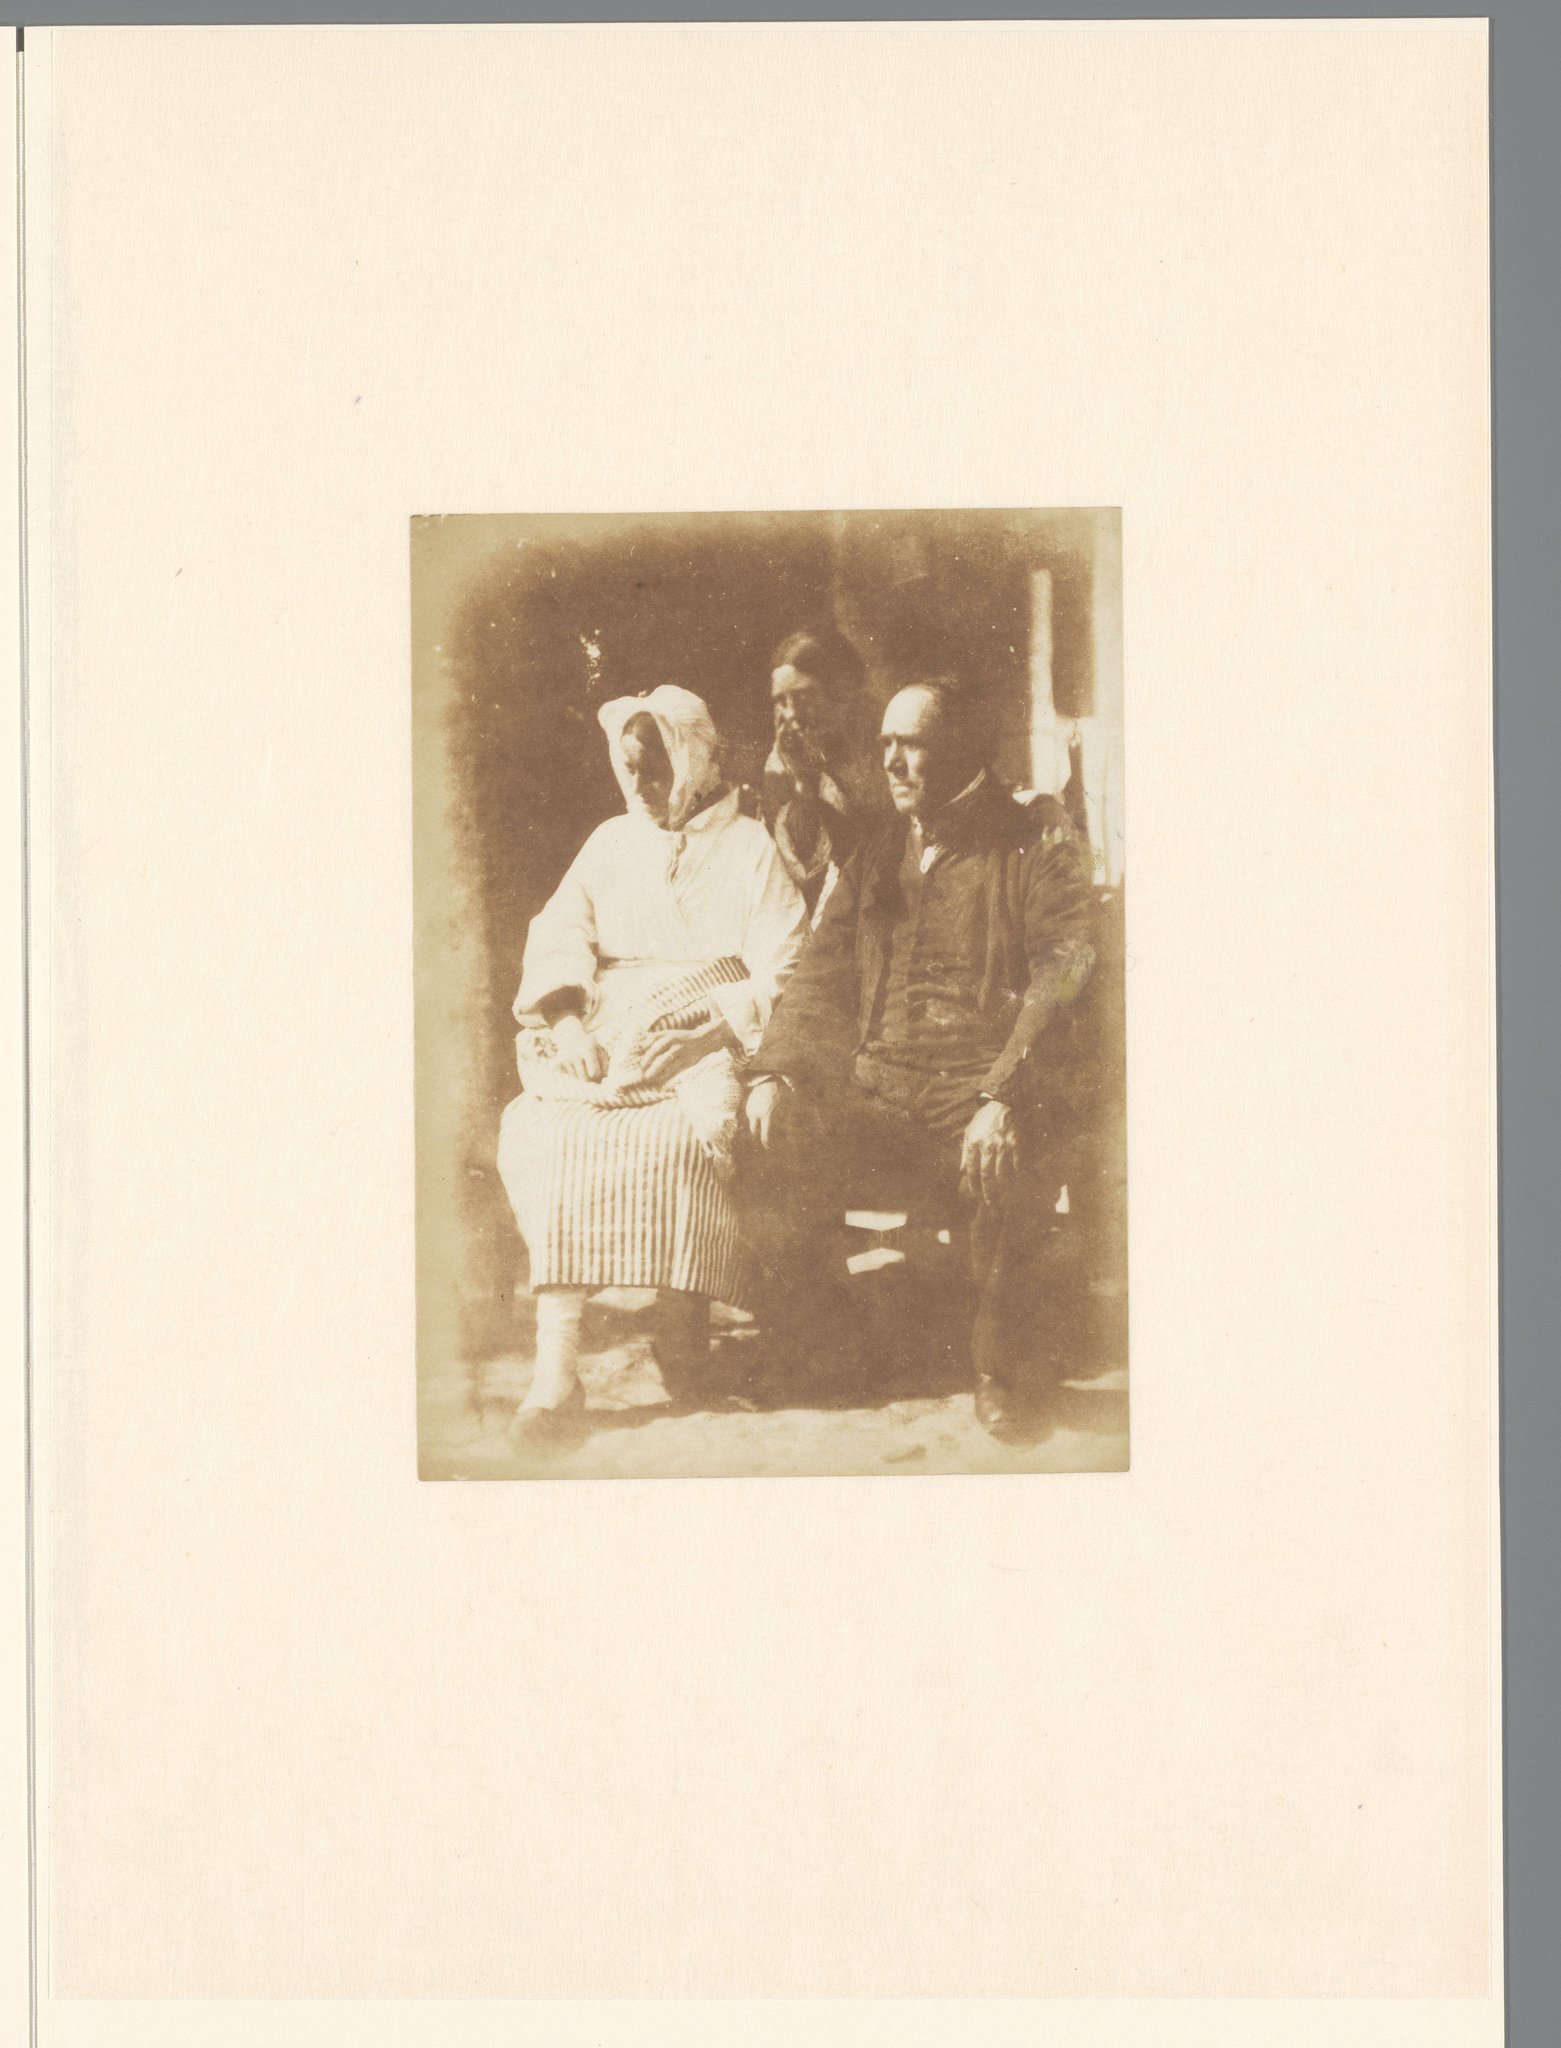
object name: photograph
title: Twee onbekende vrouwen en een man, mogelijk genaamd Laidlaw, in Newhaven, Edinburgh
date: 1843-1847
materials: photographic support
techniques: salted paper print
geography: edinburgh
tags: adult woman, adult man